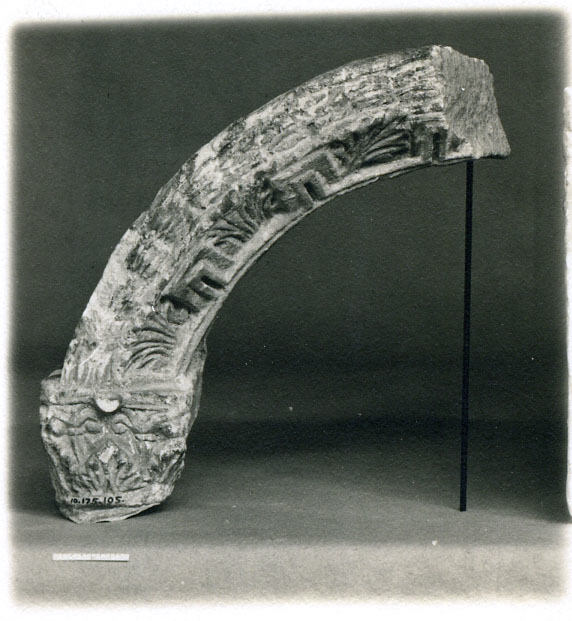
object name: fragment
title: Fragment of Archivolt with a Corinthian Capital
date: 501-700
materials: limestone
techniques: carving, relief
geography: egypt